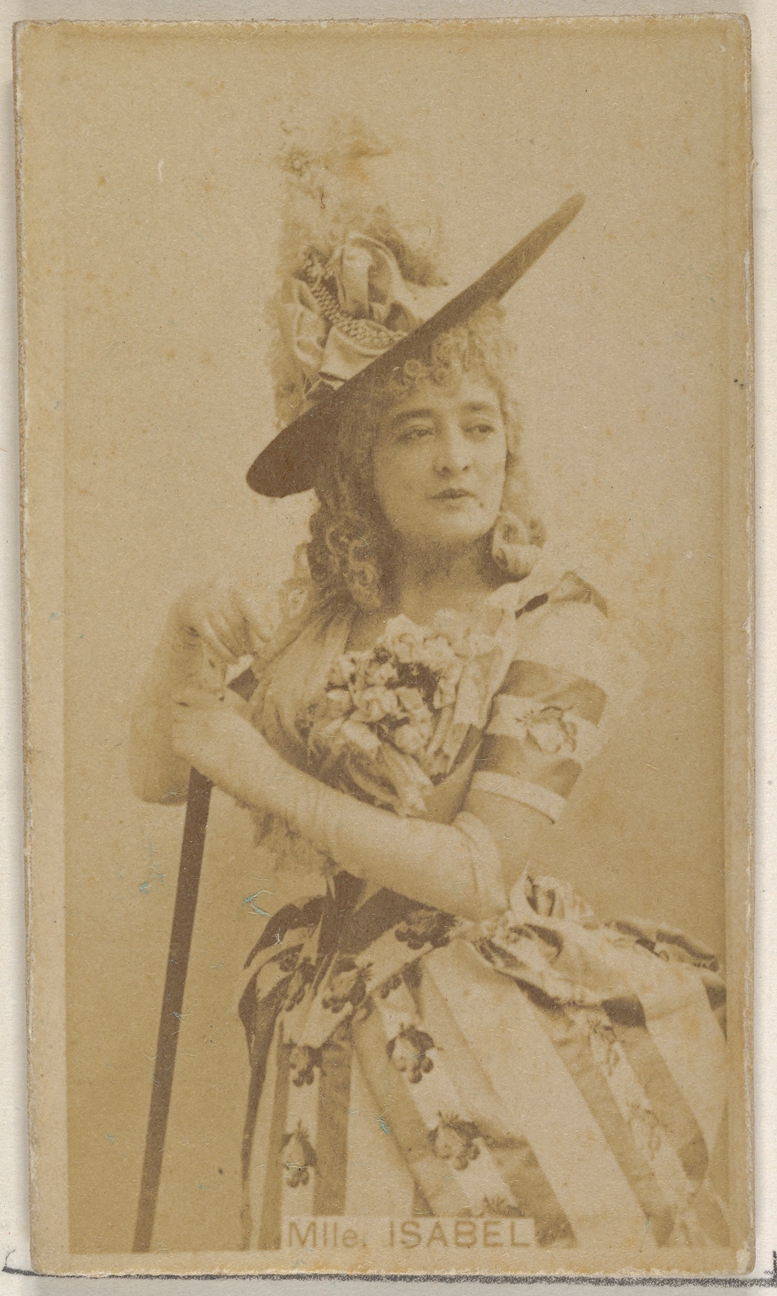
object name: photograph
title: Mlle. Isabelle, from the Actors and Actresses series (N45, Type 8) for Virginia Brights Cigarettes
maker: allen & ginter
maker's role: publisher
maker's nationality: american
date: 1888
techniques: albumen silver print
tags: portraits,women,actresses